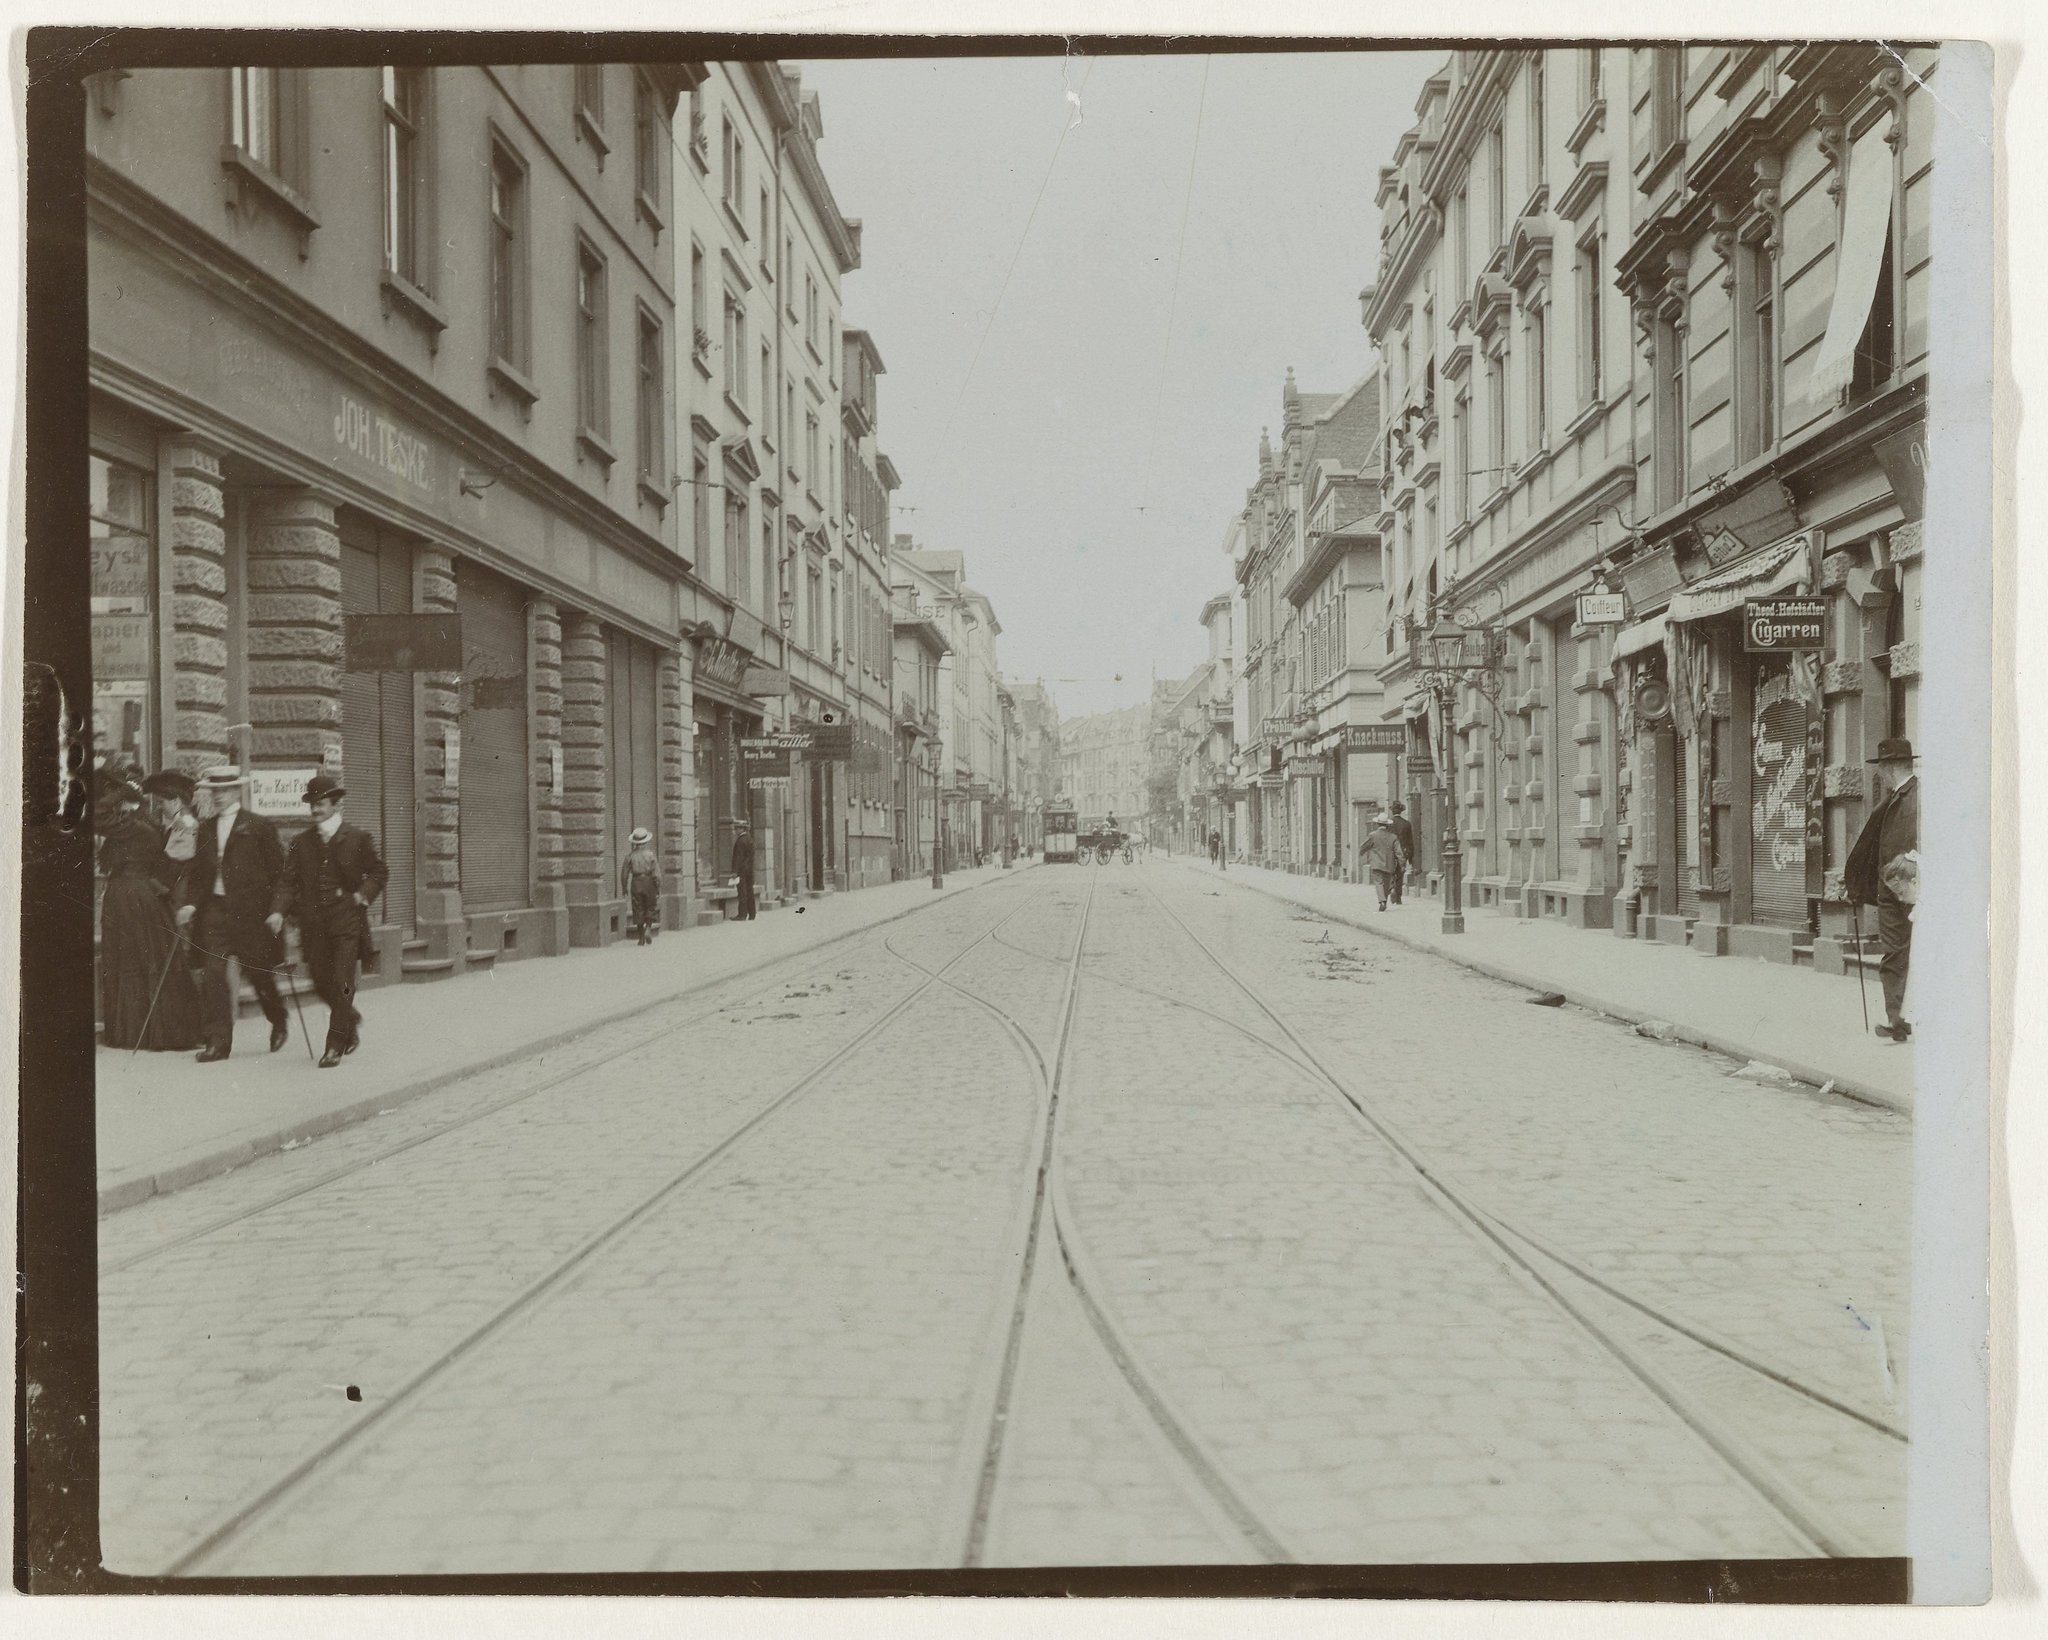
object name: photograph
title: Gezicht in een stad, mogelijk in Duitsland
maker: Anonymous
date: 1900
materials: paper, photographic support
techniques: collodion silver print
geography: germany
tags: tramway, tram, street (+ city(-scape) with figures, staffage), germany